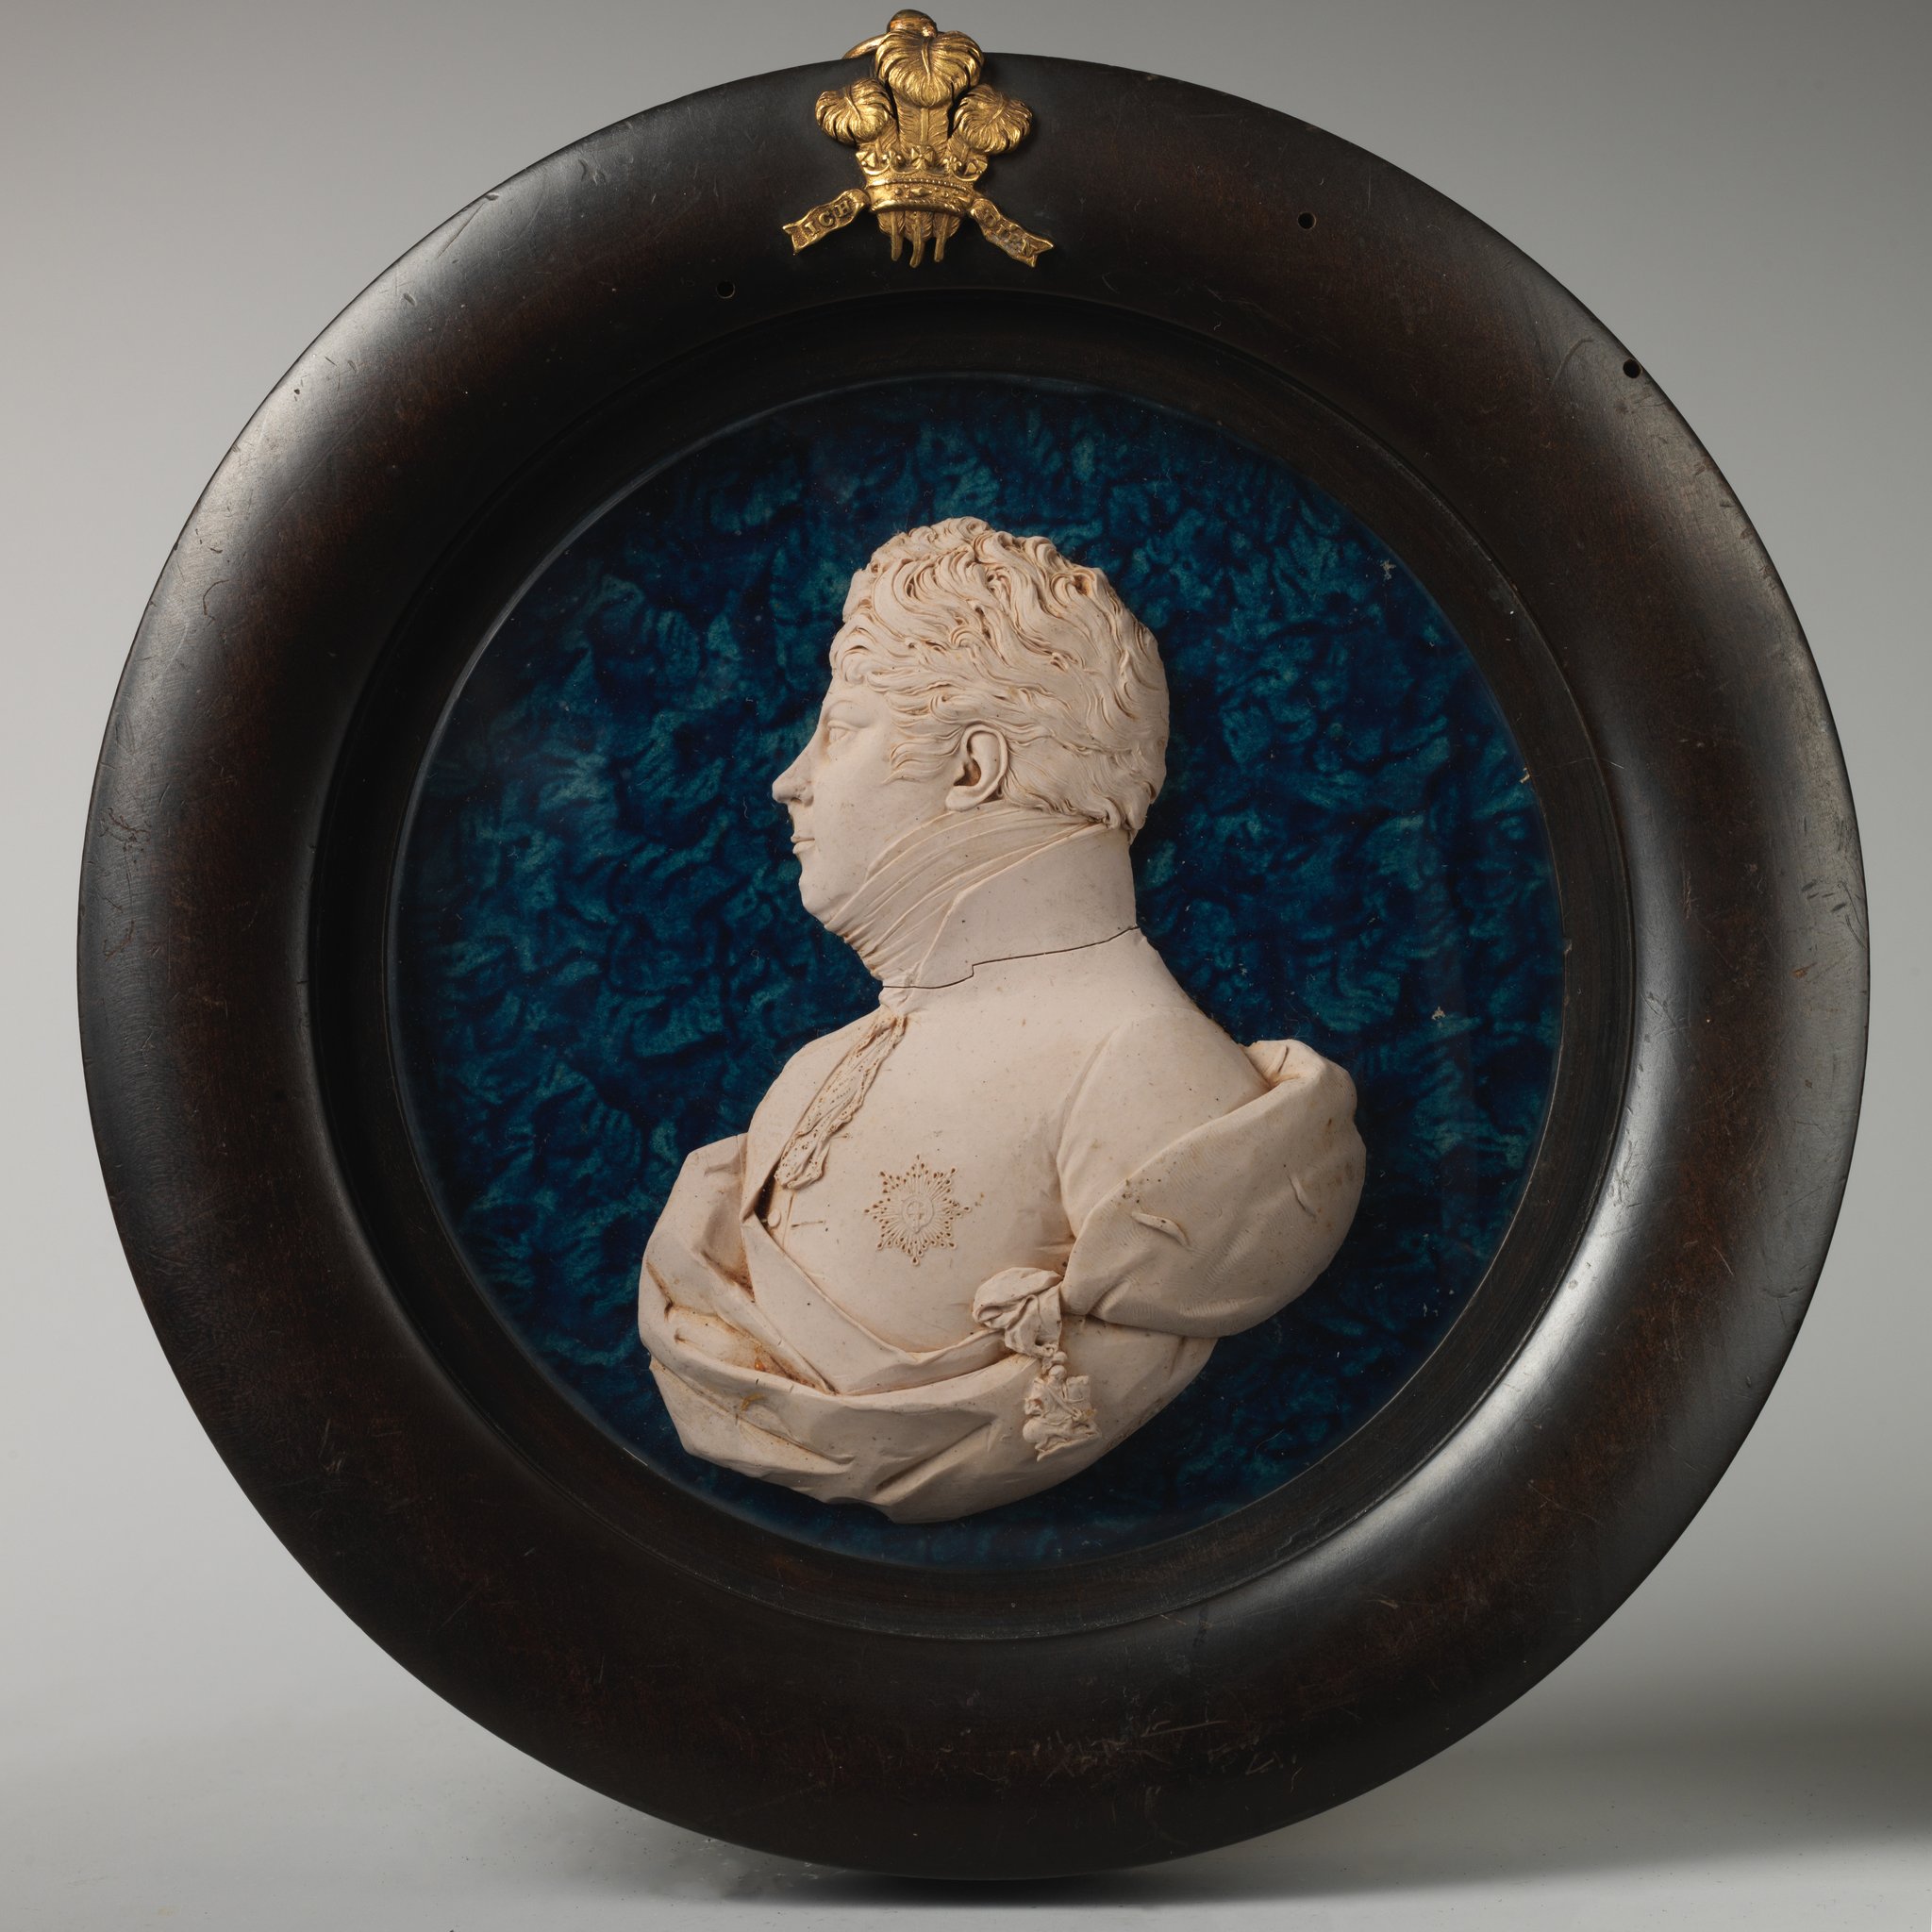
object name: medallion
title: George Augustus Frederick, Prince of Wales (1762–1830), afterwards George IV of England (1820–1830)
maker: t. r. poole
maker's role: artist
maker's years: 1721-1821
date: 1801-1900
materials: brass, glass, velvet, wax, wood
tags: princes,profiles